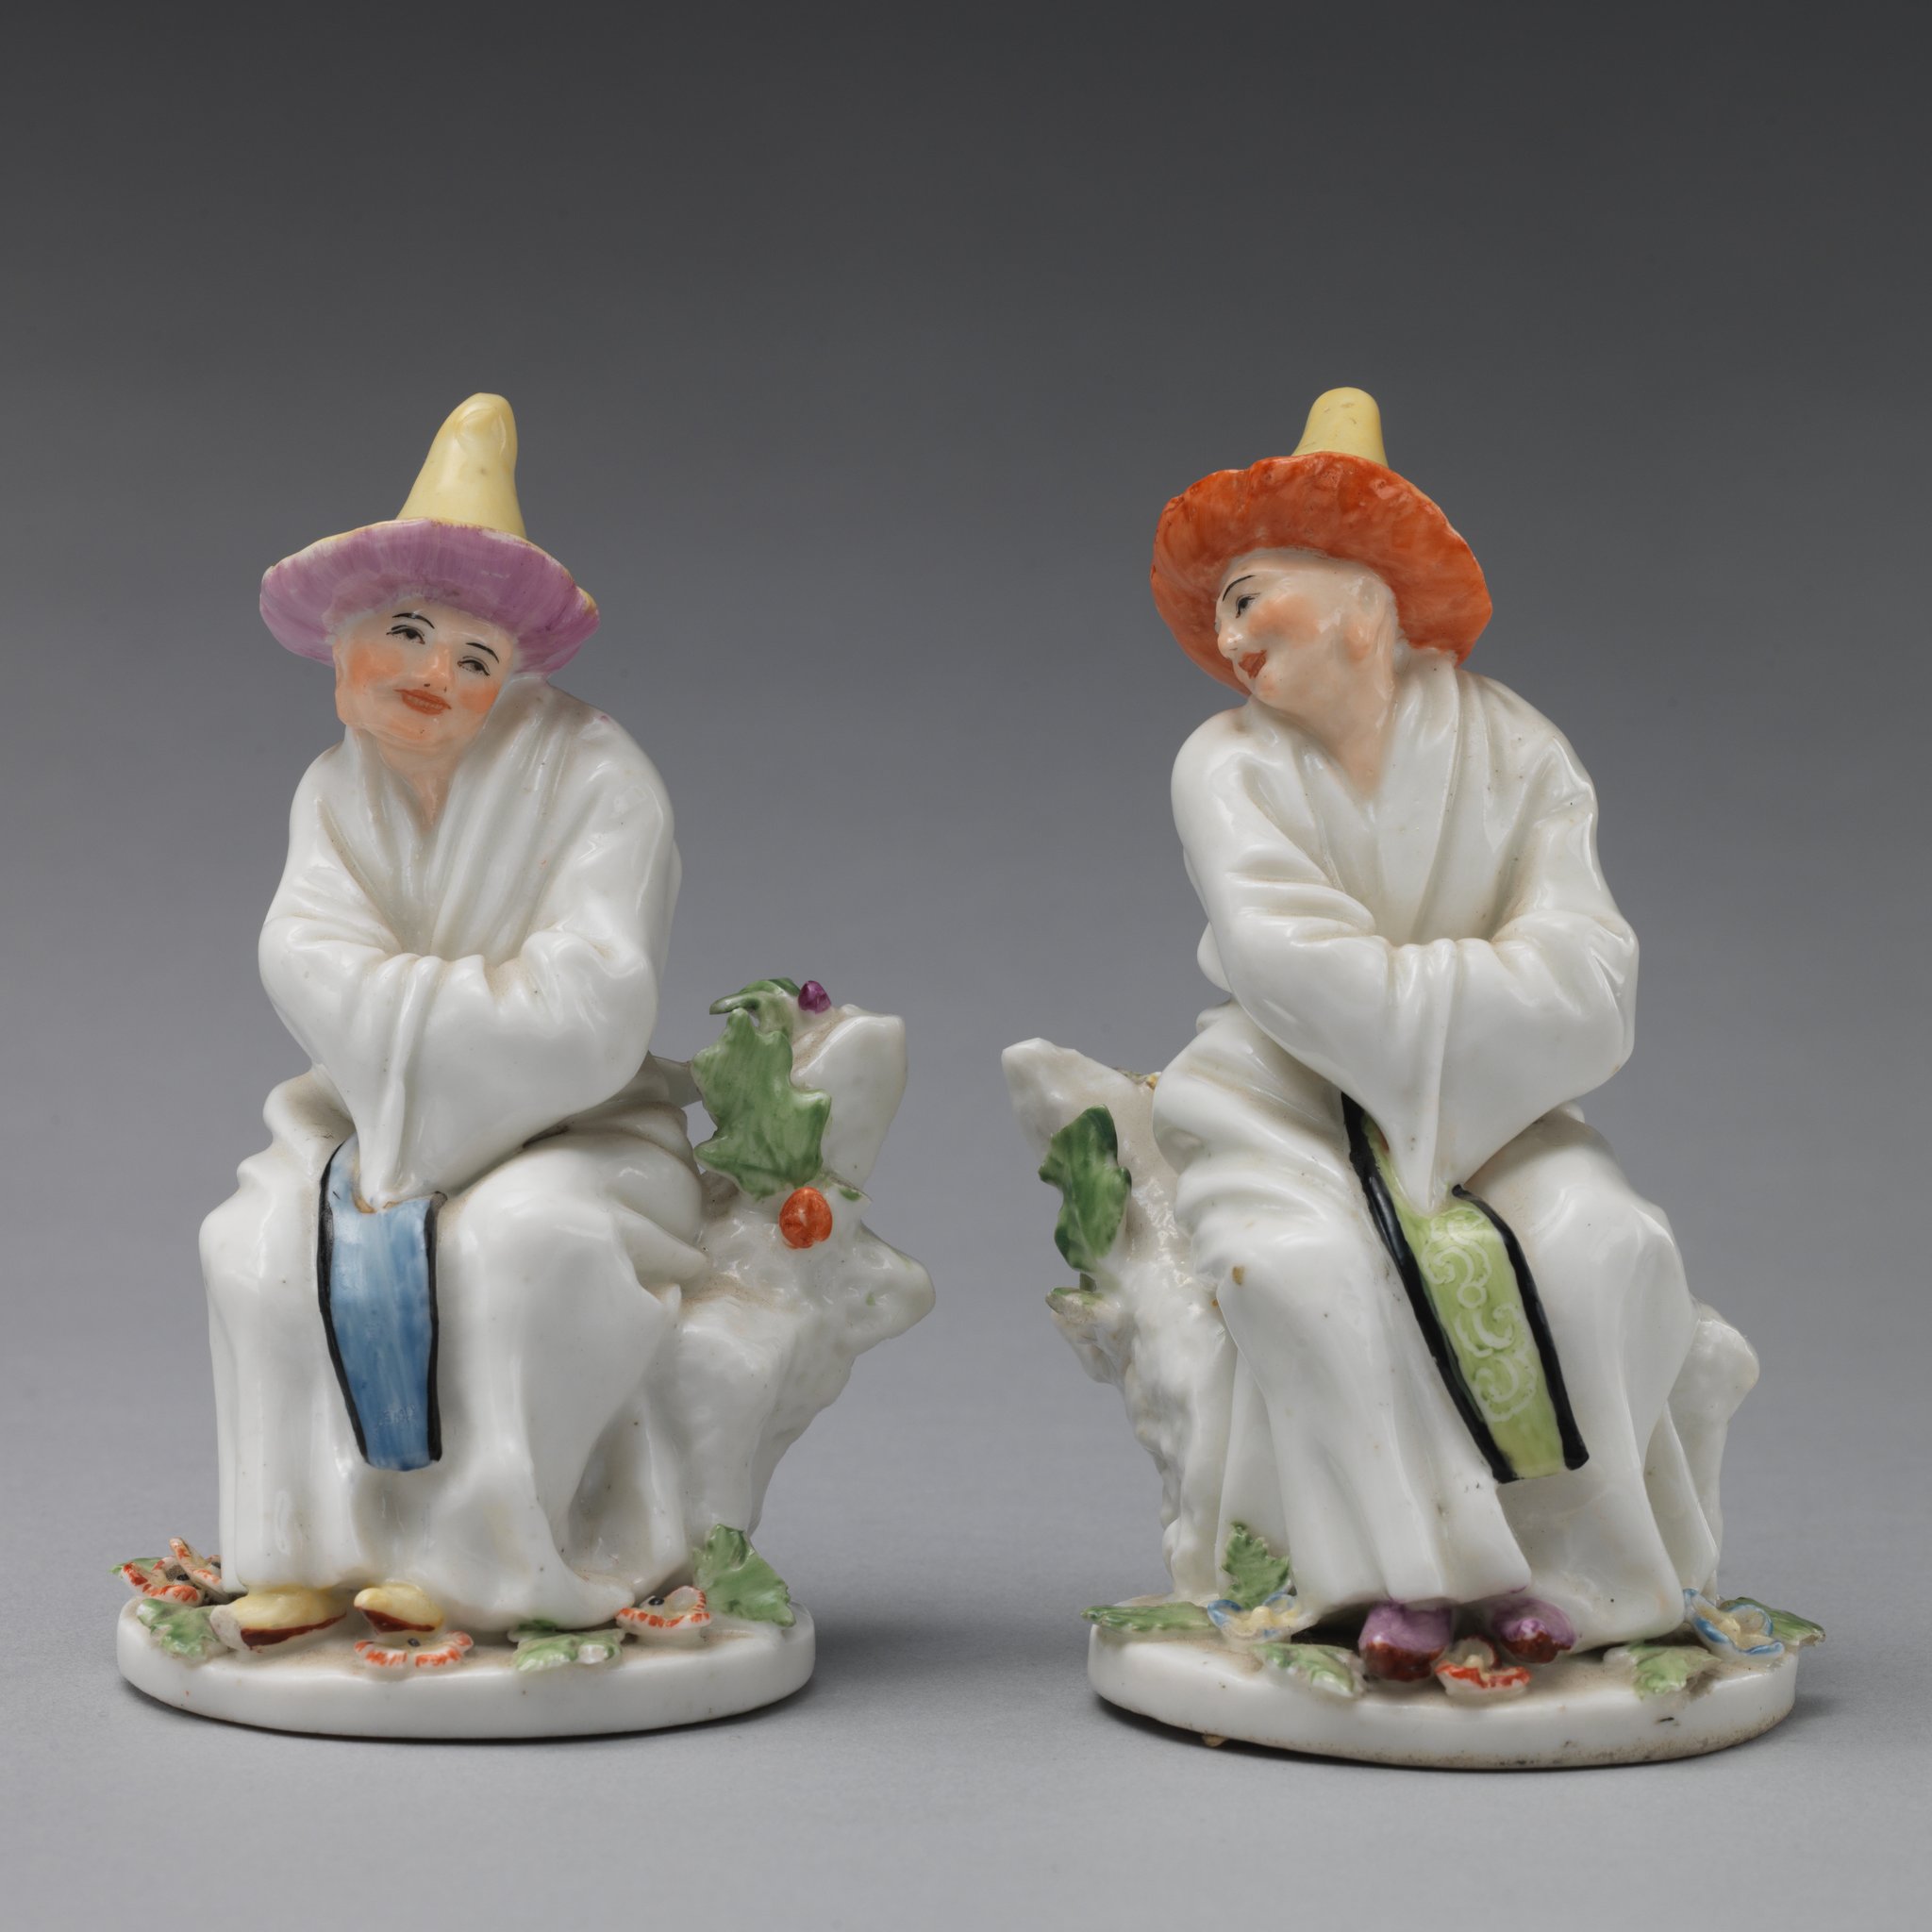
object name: figure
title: Pair of Chinese figures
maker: chelsea porcelain manufactory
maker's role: factory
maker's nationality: british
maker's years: 1744-1784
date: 1752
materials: soft paste porcelain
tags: men